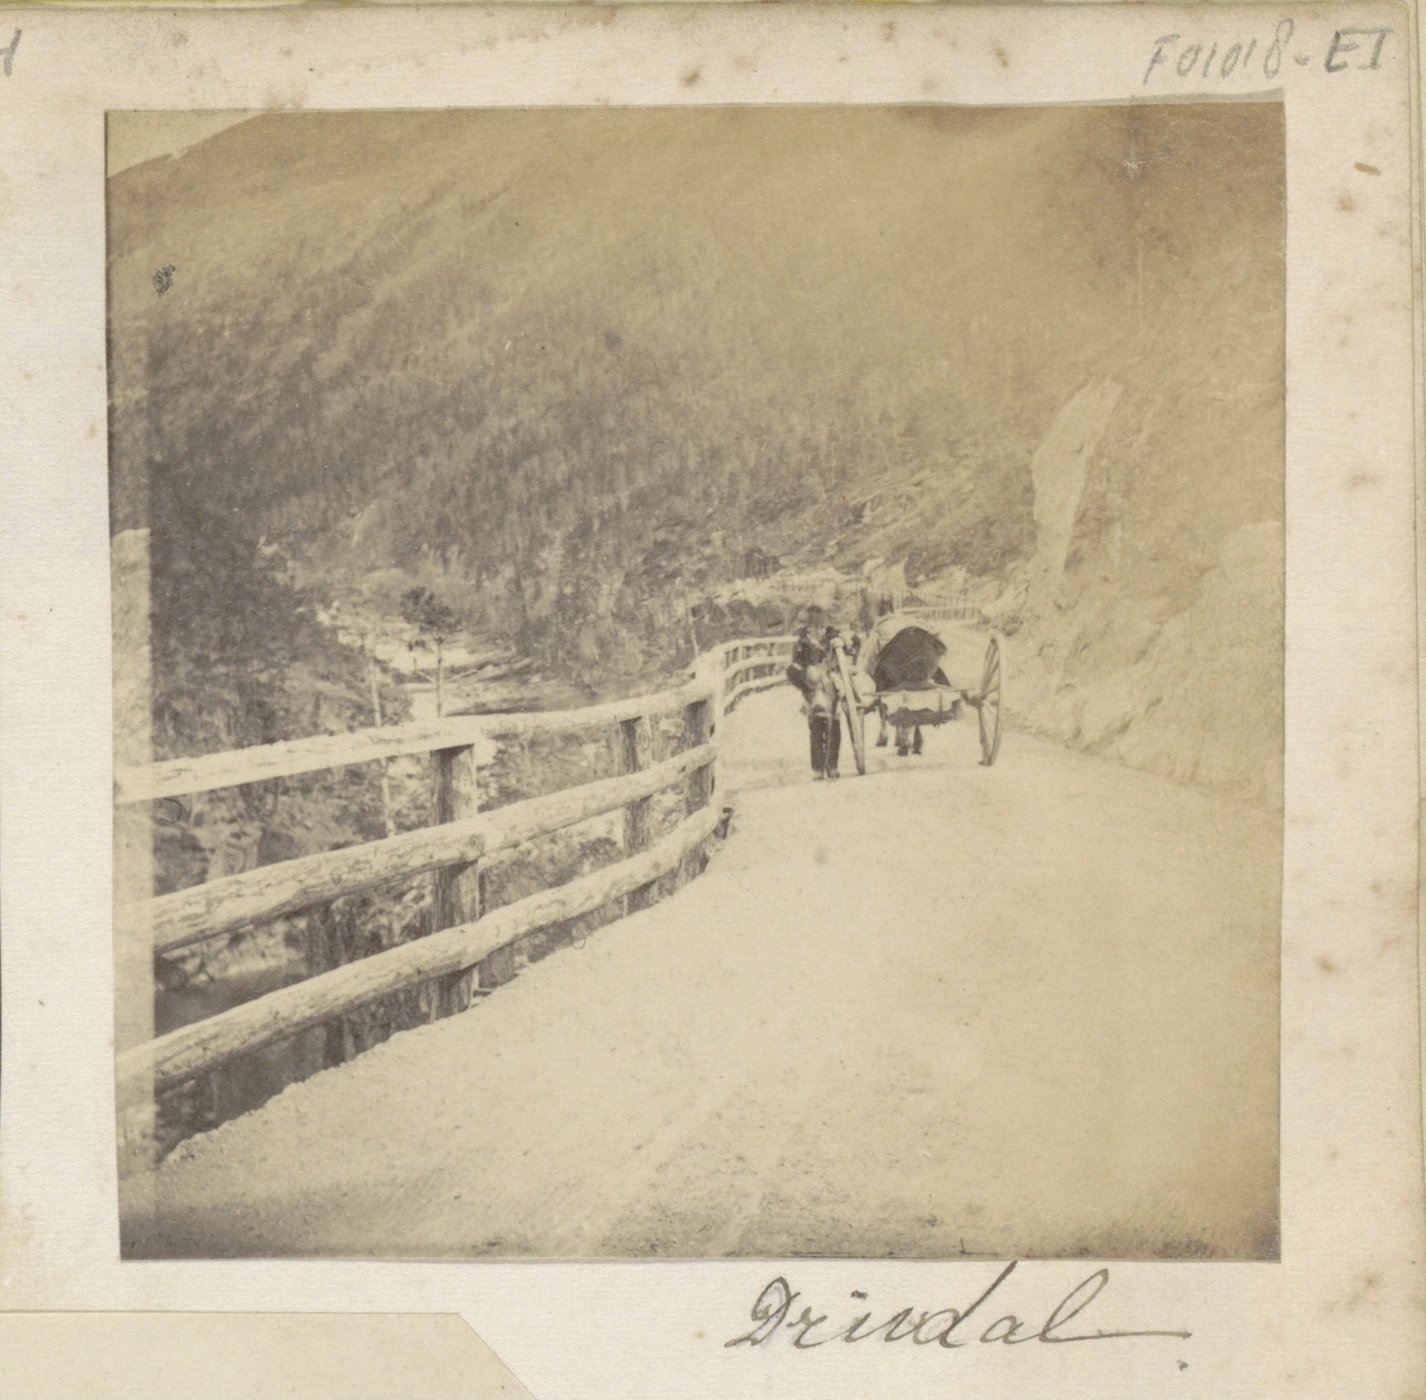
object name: photograph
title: Man met paard en wagen op een weg in Drivdalen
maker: Anonymous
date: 1860-1870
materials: paper, photographic support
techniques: albumen print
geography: drivdalen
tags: two-wheeled, animal-drawn vehicle, public road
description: Onderdeel van Engels familiealbum met foto's van personen, reizen, cricket en kunstwerken.